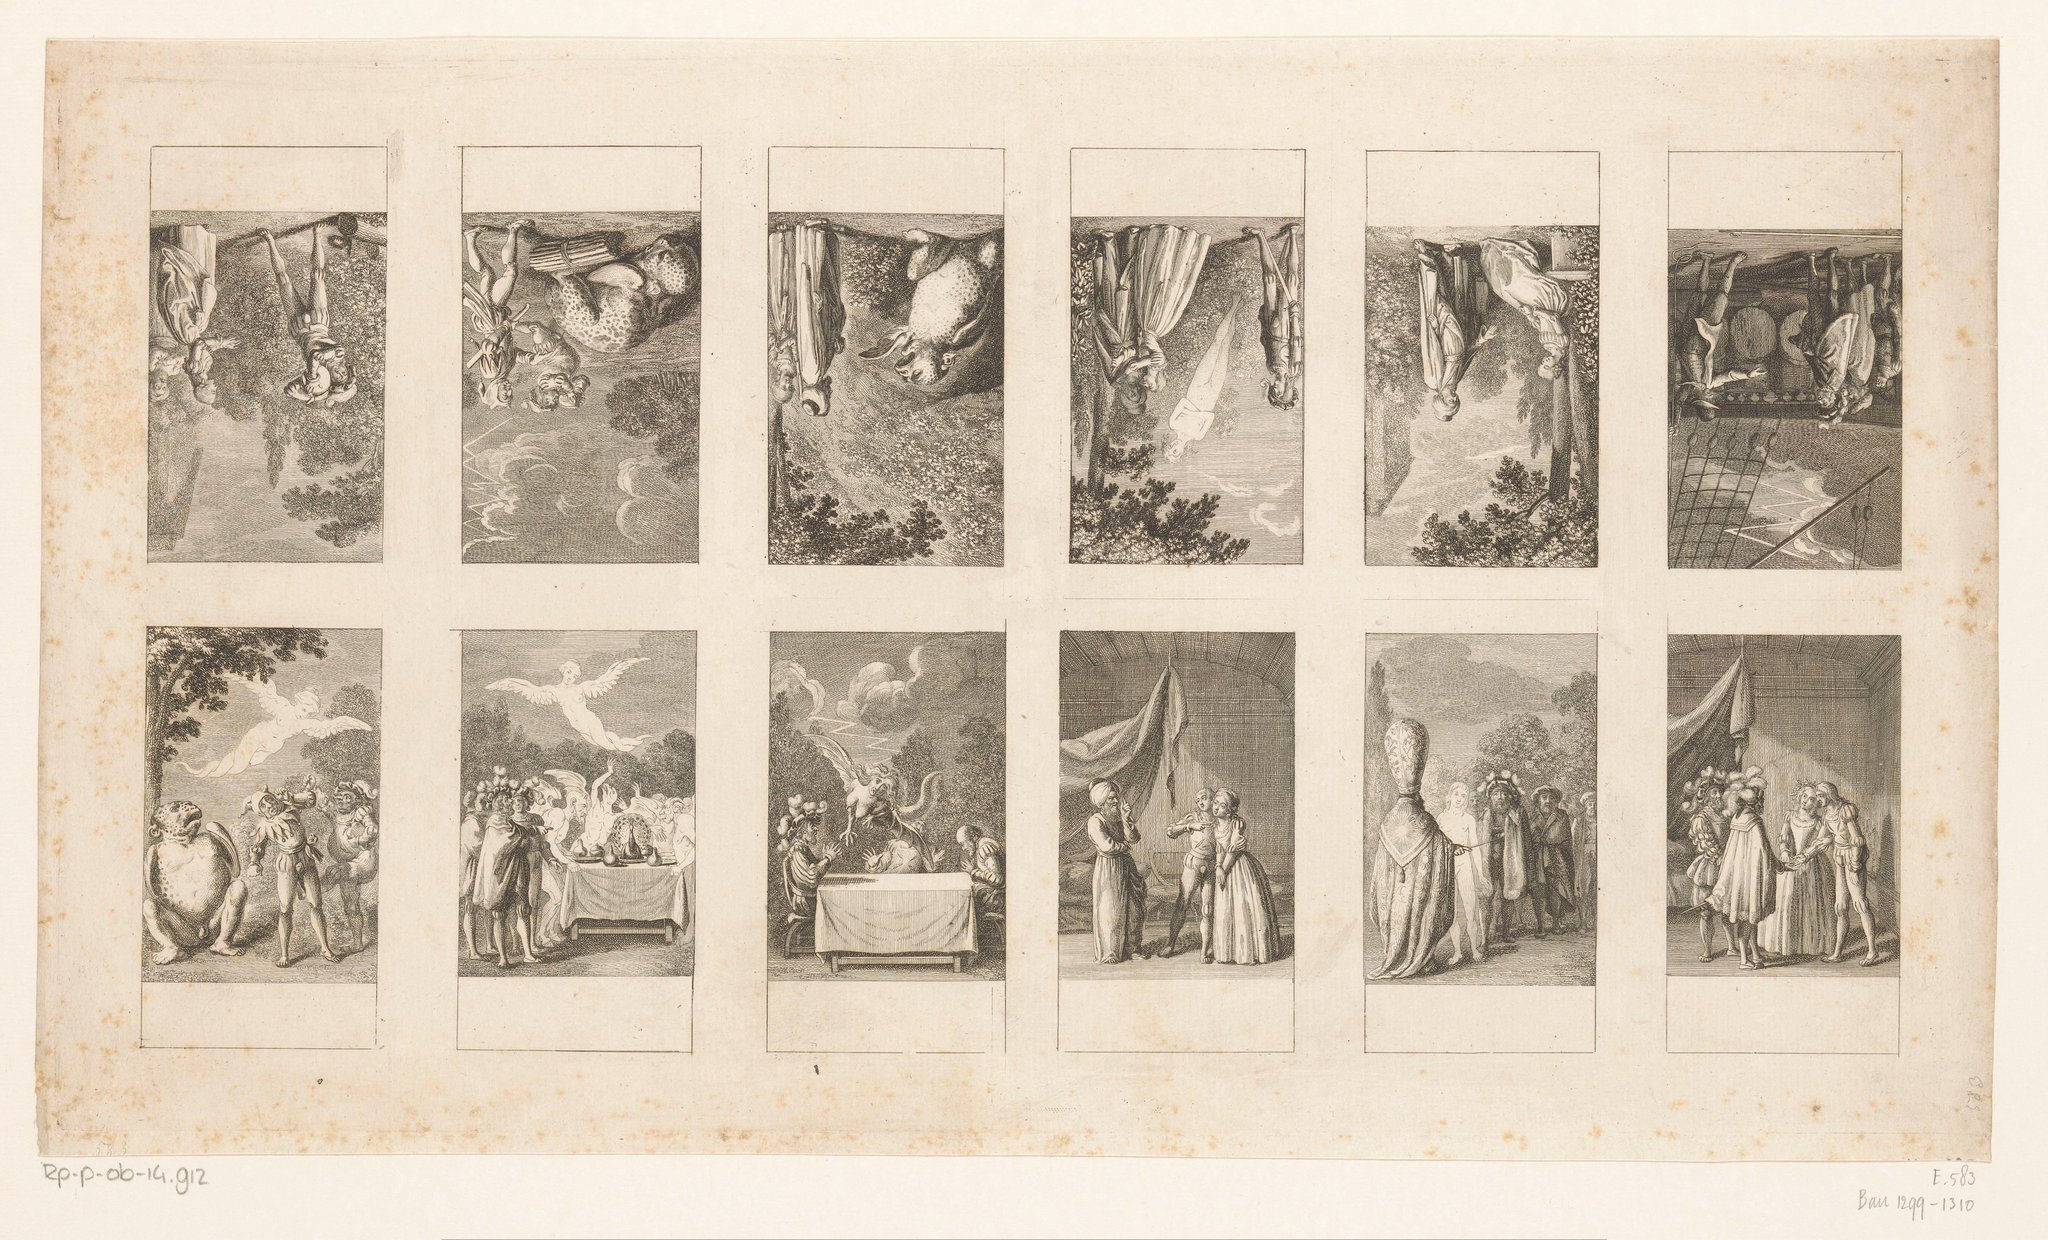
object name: print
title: Twaalf voorstellingen uit Shakespeare's De Storm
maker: daniel nikolaus chodowiecki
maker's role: draughtsman, print maker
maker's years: 1726-1801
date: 1787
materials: paper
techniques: etching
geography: berlin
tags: william shakespeare, court jester, court fool, sailing-ship, sailing-boat, literature, monsters of mixed human and animal shape; 'mostri' (ripa), sorcerer, magician, wizard, warlock, spirit, ghost, storm, harpy (fabulous bird); 'arpie' (ripa)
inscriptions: collector's mark: Lugt 2228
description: Twaalf voorstellingen met betrekking tot Shakespeare's toneelstuk 'Der Sturm', tezamen gedrukt op een vel. 'De Storm' vertelt het verhaal van de verbannen hertog van Milaan, Prospero, en zijn dochter Miranda. Prospero is na het verraad van zijn broer, samen met zijn dochter op een onbewoond eiland gestrand. Na enkele jaren komt zijn broer, Antonio, met gevolg langs het eiland gevaren. Prospero, nu een machtig magiër geworden, roept een storm aan en zorgt dat het schip tegen de klippen loopt. De verschillende opvarende worden verspreid over het eiland wakker. Op hun tocht over het eiland komen ze magische wezens, aangevoerd door de luchtgeest Ariël, tegen en zo ook het volgzame monster Caliban. Onder de opvarende is tevens de jonge Ferdinand, zoon van de huidige koning van Napels. Miranda wordt verliefd op de jongen en smeekt haar vader of ze met hem mag trouwen. In de dynamische conclusie van het stuk komt Prospero tot inkeer en ziet af van zijn wraak acties. Gebruikt in: Dietrich, Johann Christian. Goettinger Taschen Calender vom Jahr 1788. Beij J. C. Dietrich. Göttingen: G. C. Lichtenberg, 1788.